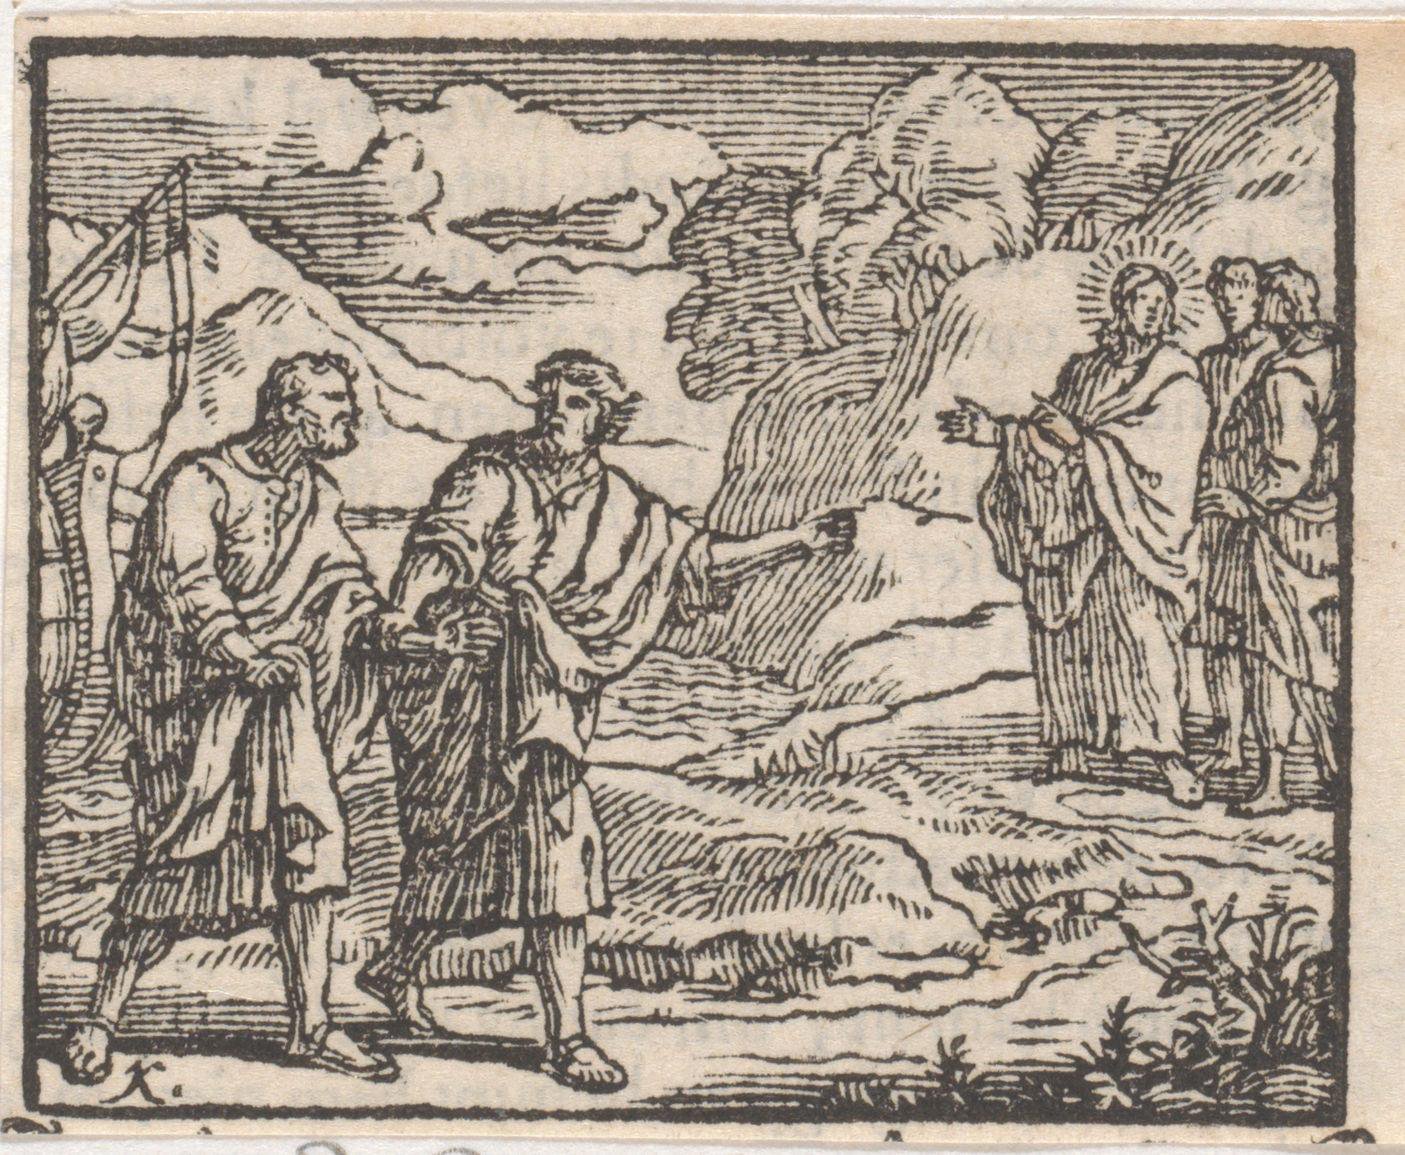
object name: book illustration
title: Roeping van de apostelen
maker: jan lauwryn krafft (i)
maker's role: print maker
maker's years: 1694-1785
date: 1704-1785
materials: paper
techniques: letterpress printing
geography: southern netherlands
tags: calling of the apostles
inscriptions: collector's mark: Lugt 2228